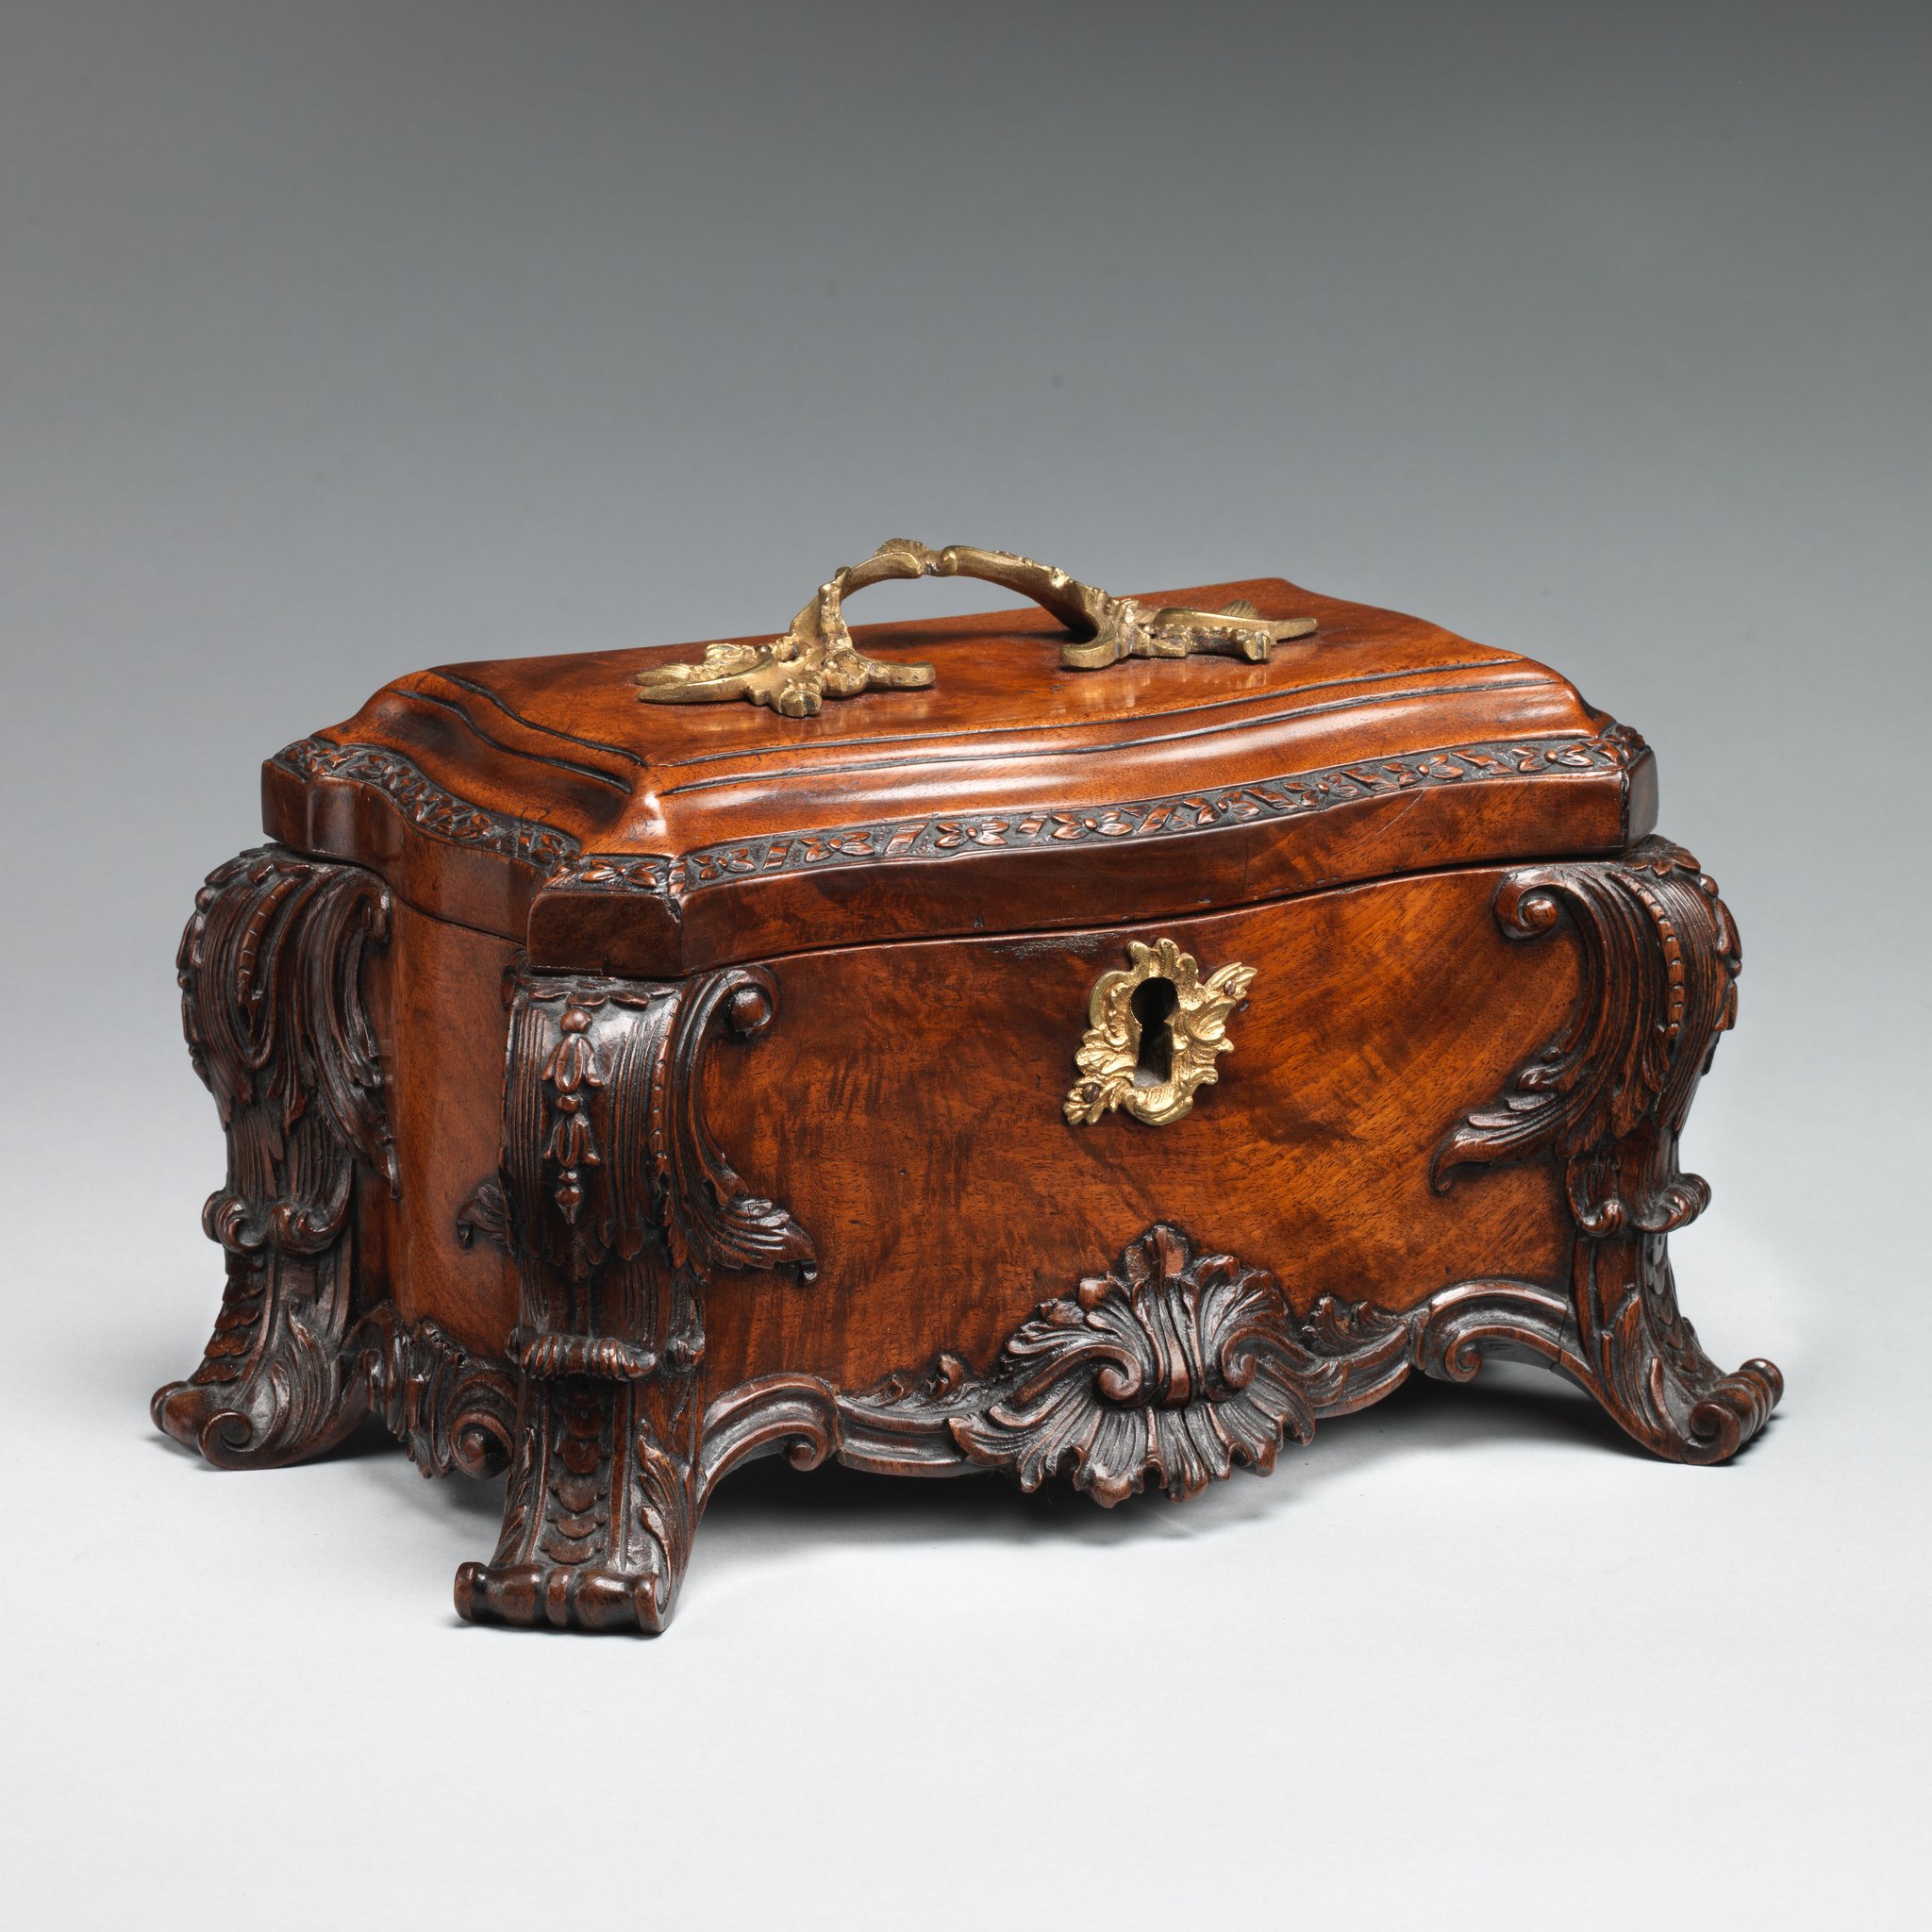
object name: tea chest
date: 1760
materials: brass, gilt, wood